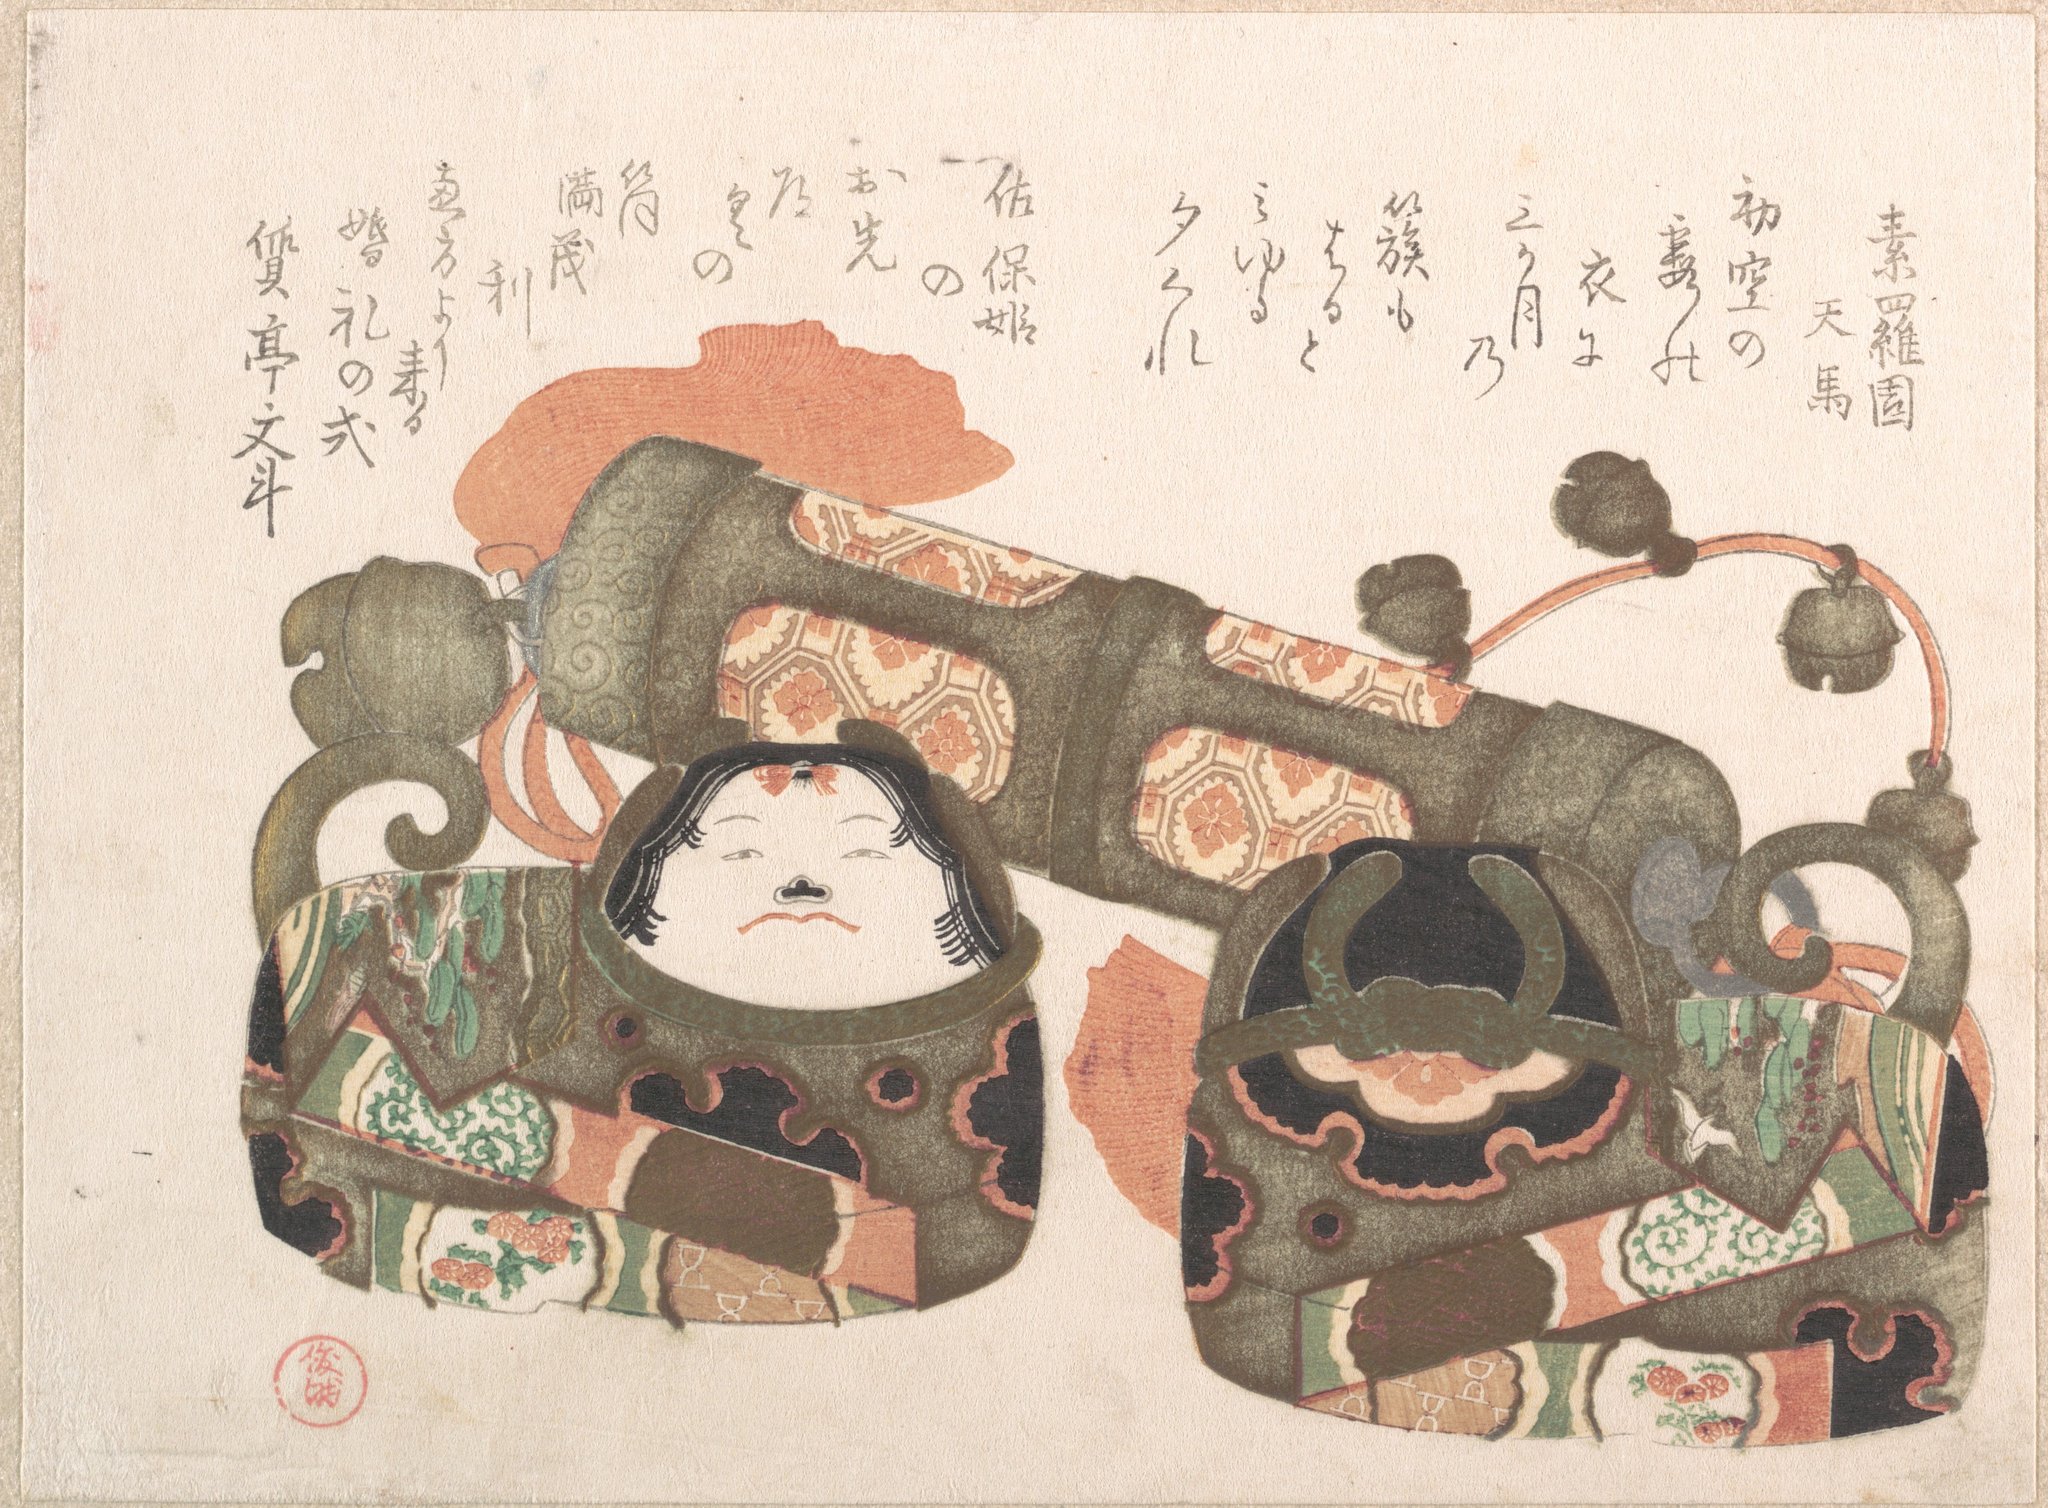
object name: print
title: Toys of Papier-Mache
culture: japanese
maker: kubo shunman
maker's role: artist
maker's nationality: japanese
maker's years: 1757-1820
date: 1801-1900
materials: ink, paper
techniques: surimono, woodblock print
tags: toys